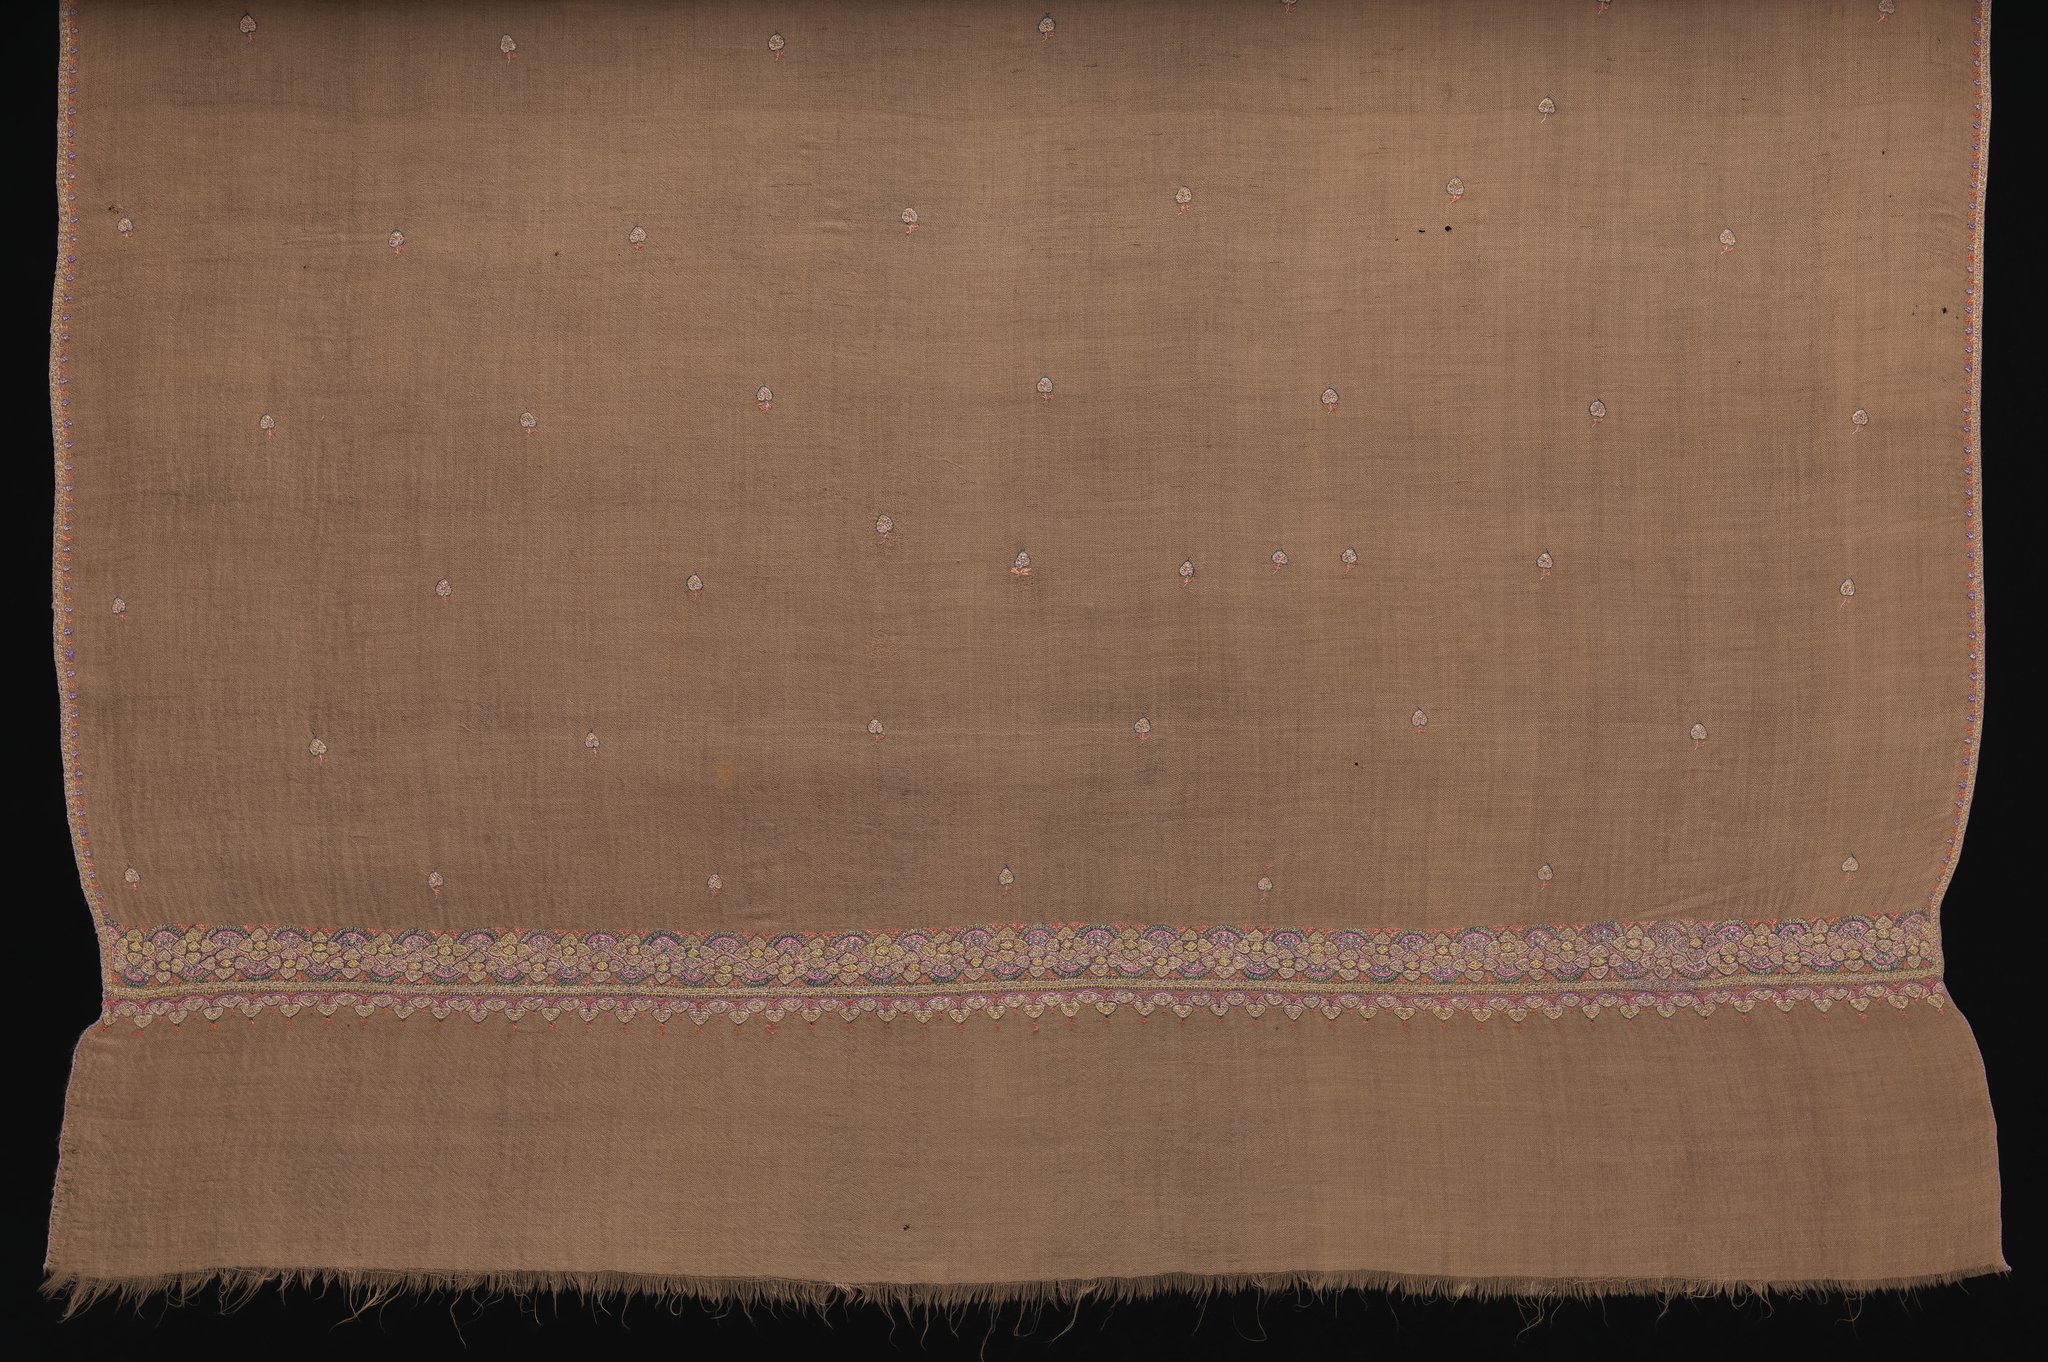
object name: shawl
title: Embroidered Shawl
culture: indian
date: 1834-1866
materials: silk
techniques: embroidery